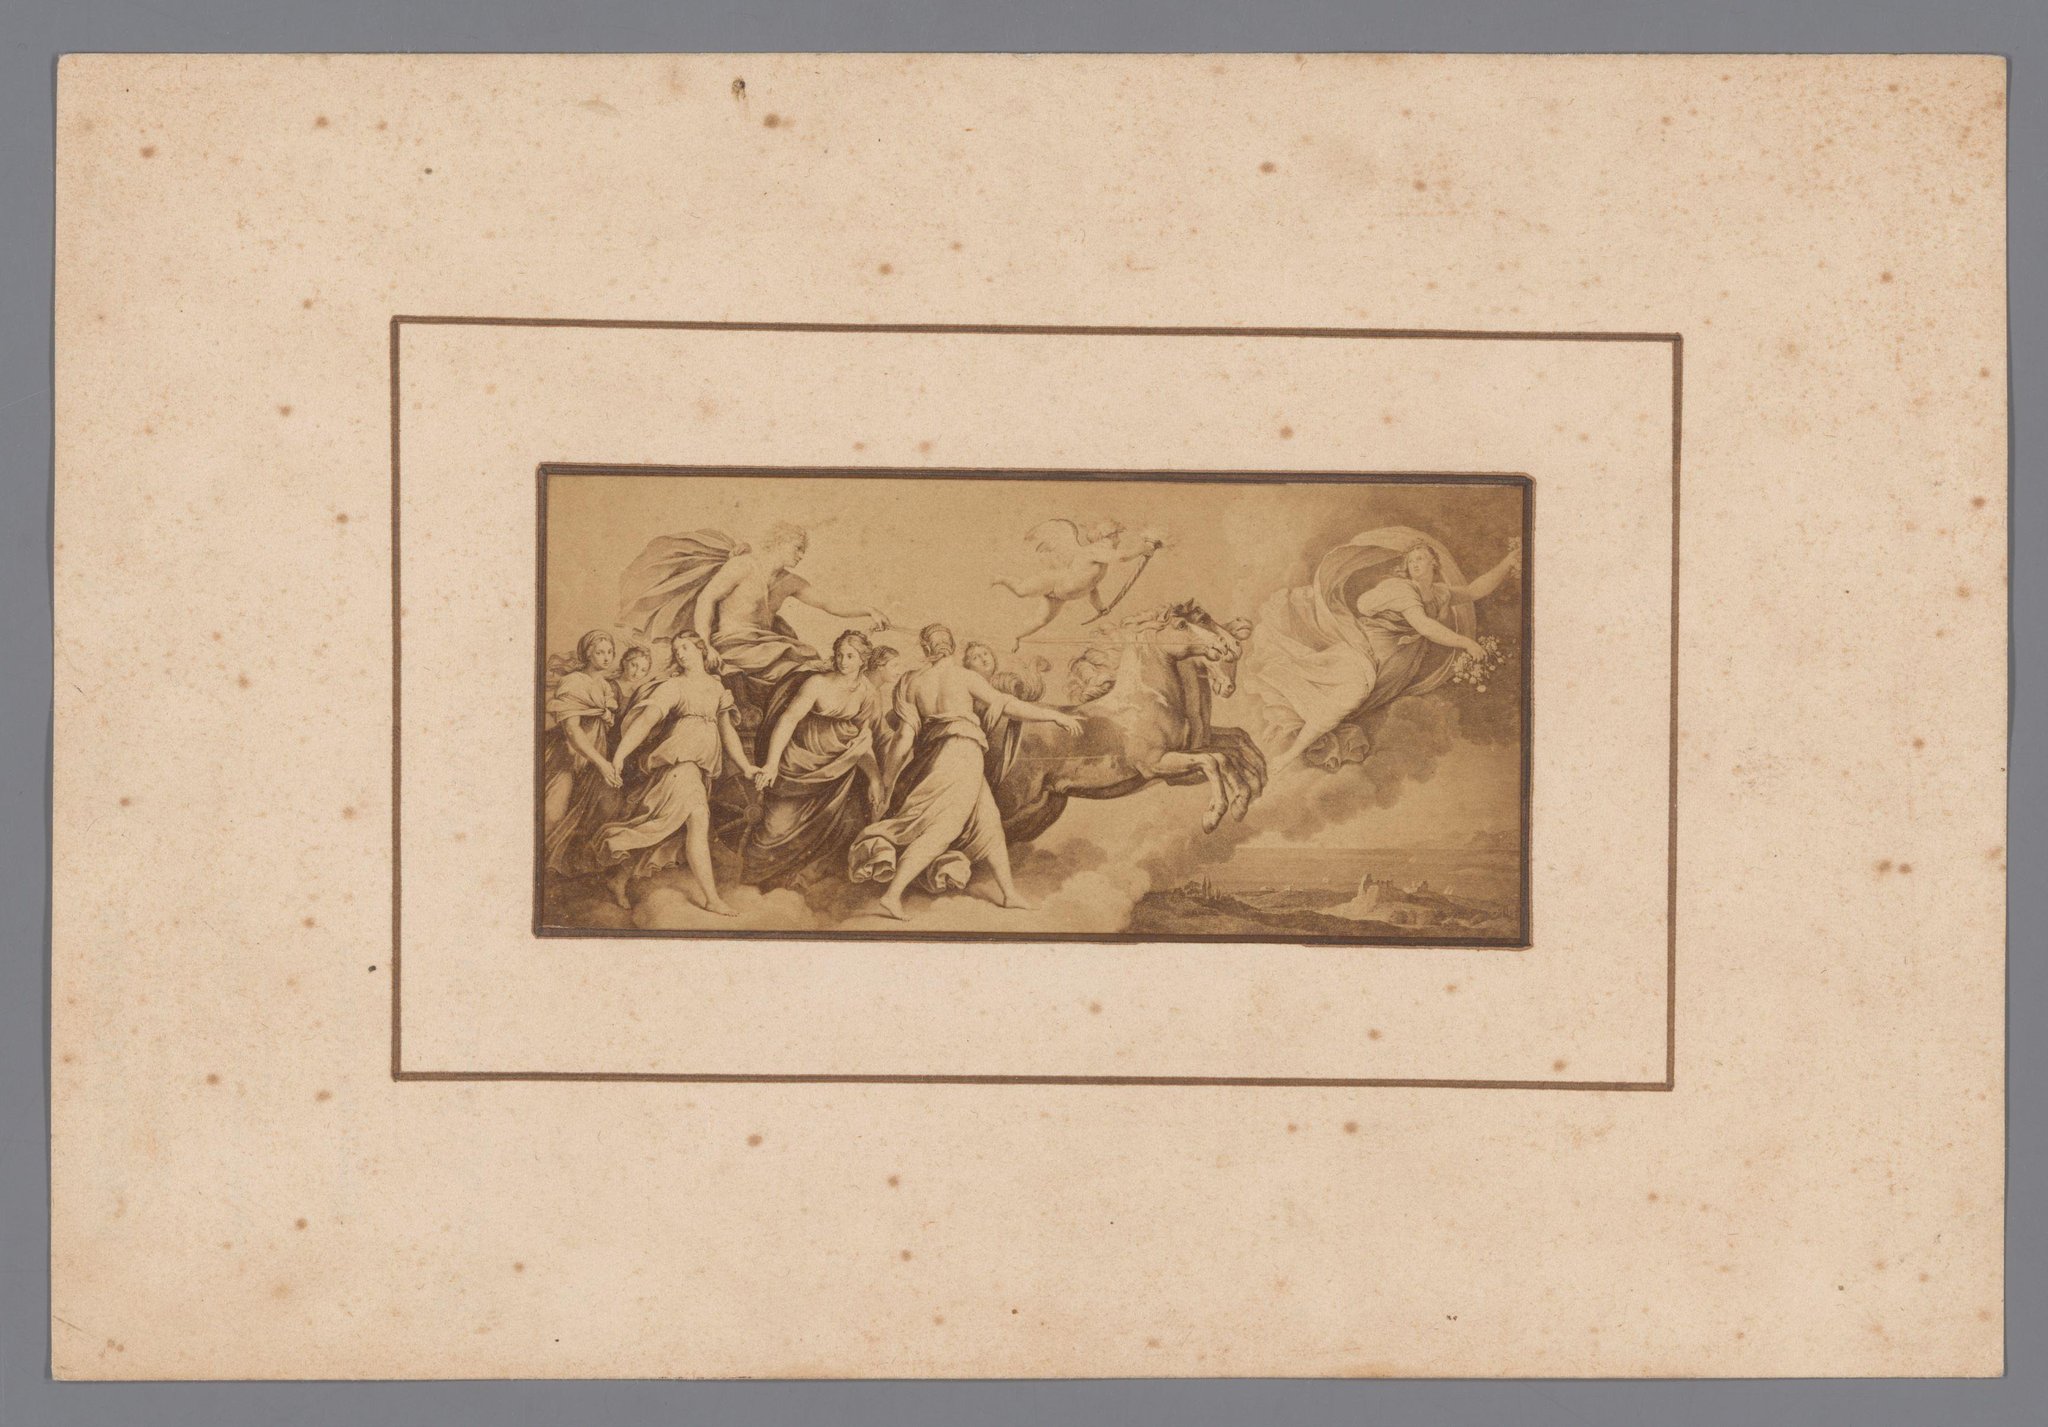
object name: photograph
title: Fotoreproductie van een schilderij van zonnegod Helios in zijn strijdwagen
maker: Anonymous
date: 1861-1893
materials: cardboard, paper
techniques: albumen print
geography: italy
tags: the chariot of the sun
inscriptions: watermark: ‘Banca Nazionale/ nel Regno d'Italia (...)’